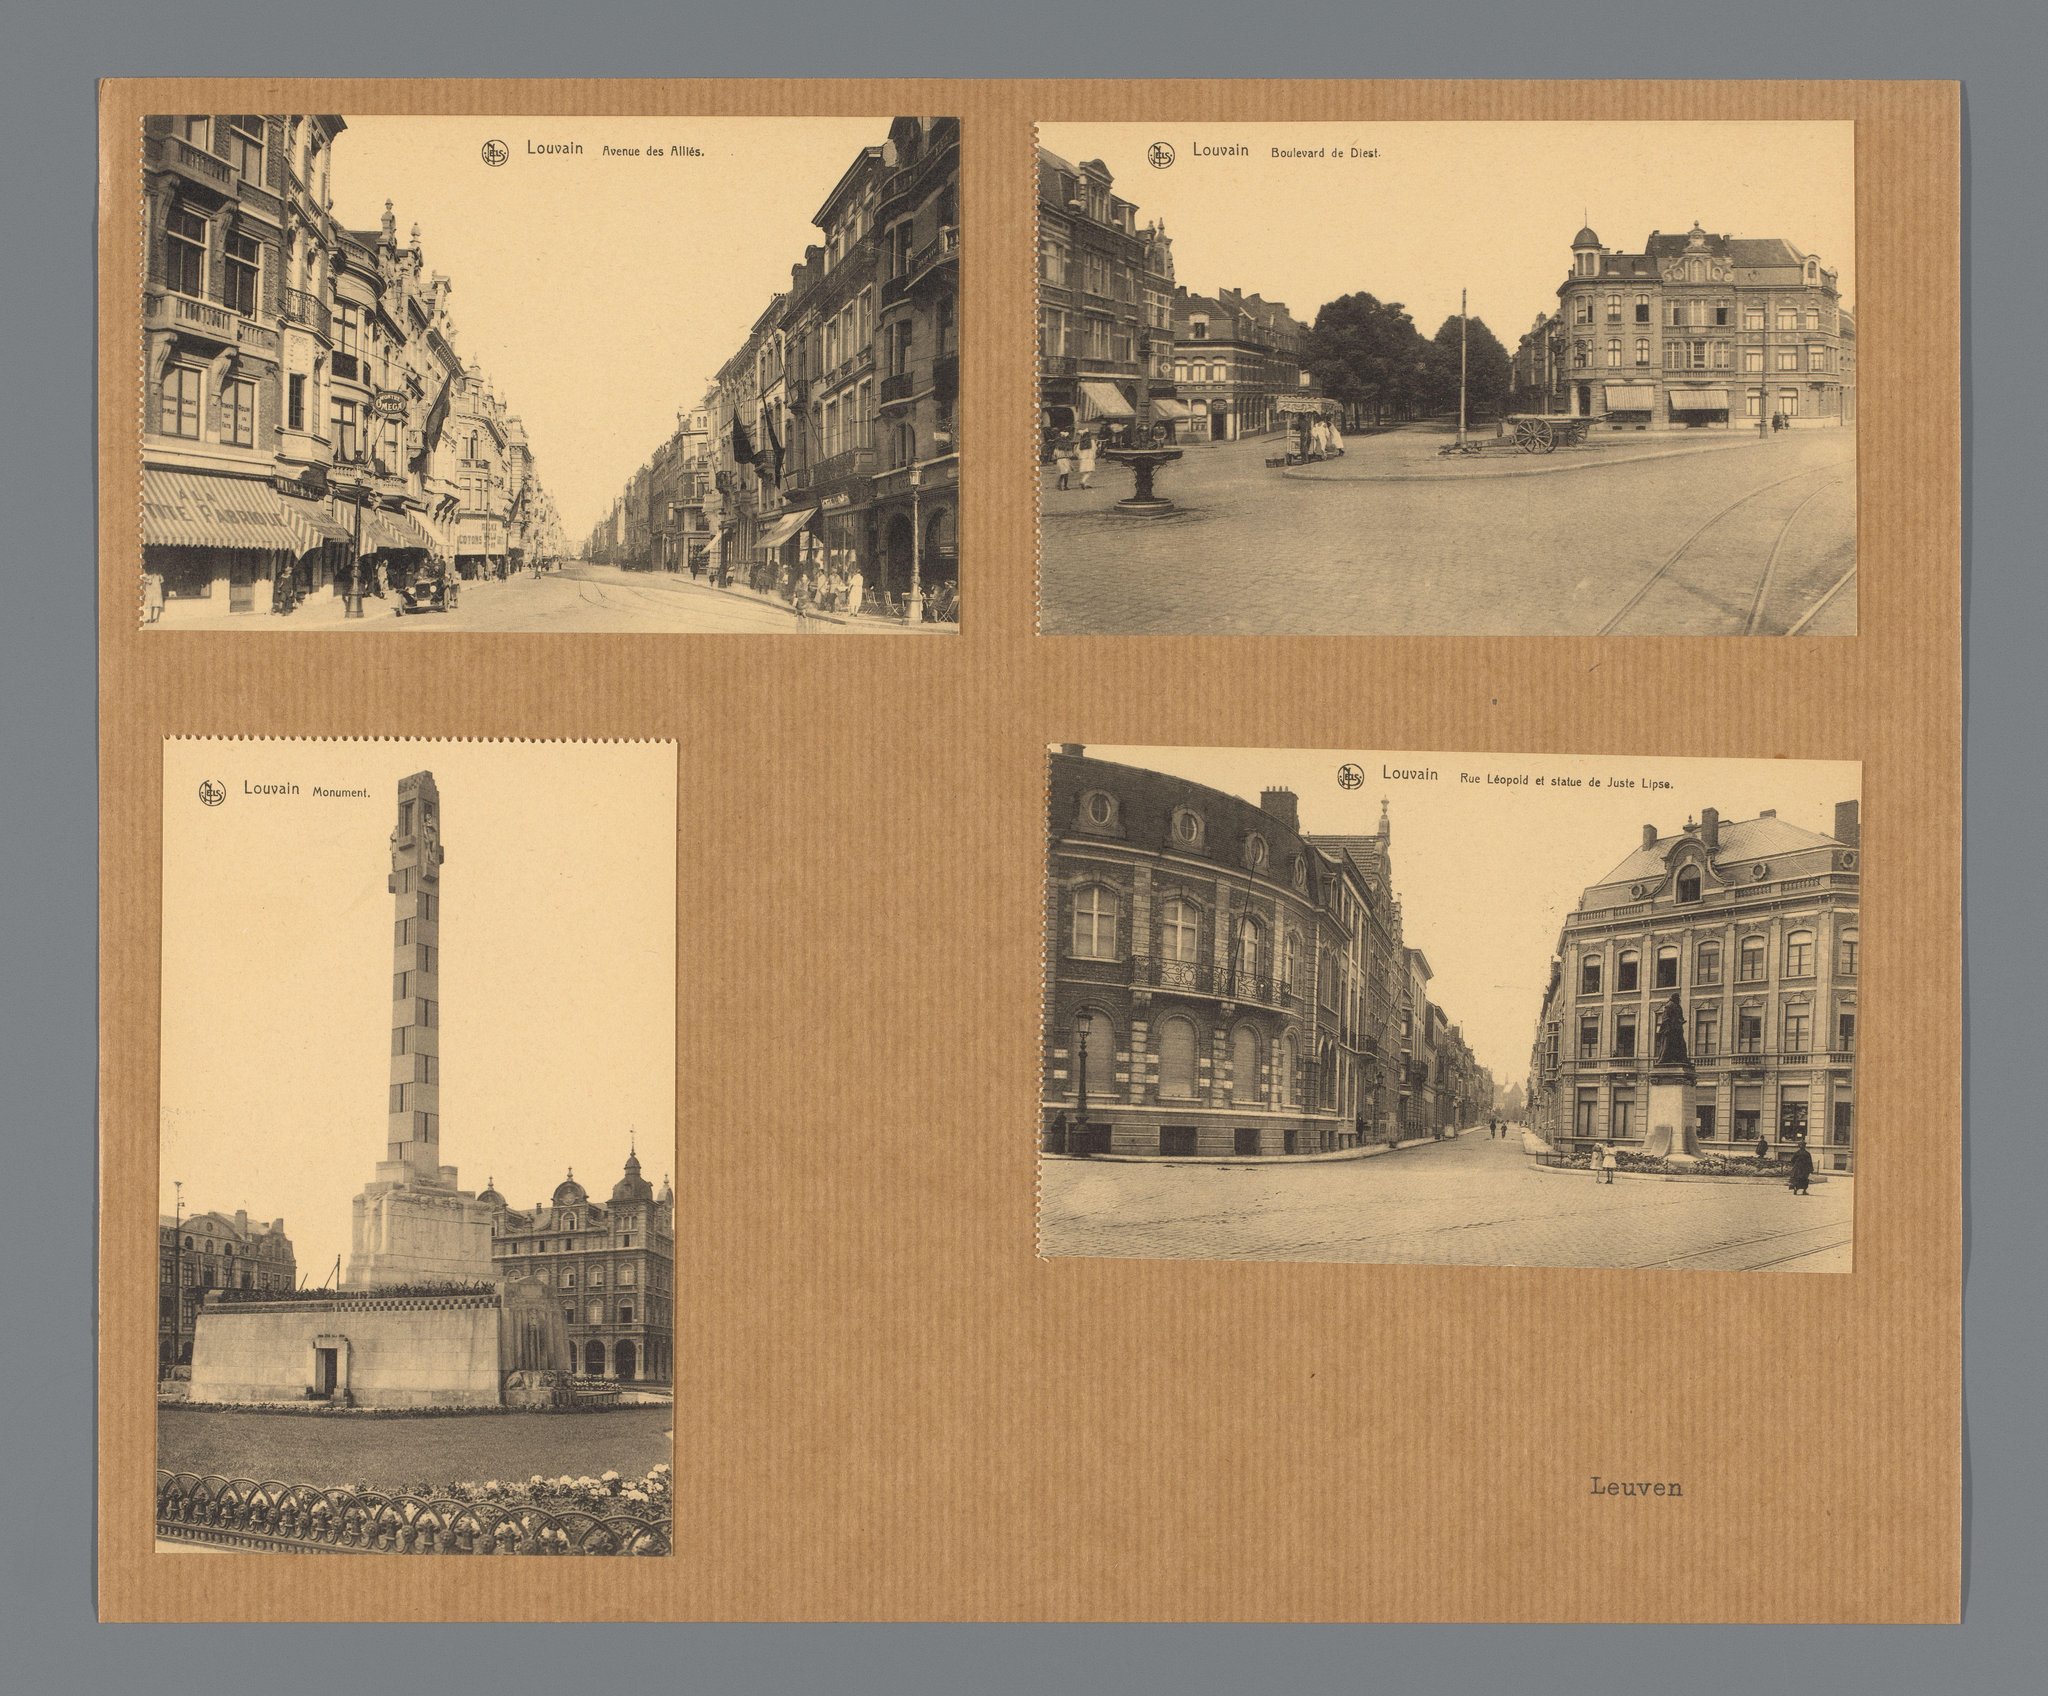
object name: photograph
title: Leuven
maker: Anonymous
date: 1860-1925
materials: photographic support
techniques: photograph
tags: louvain